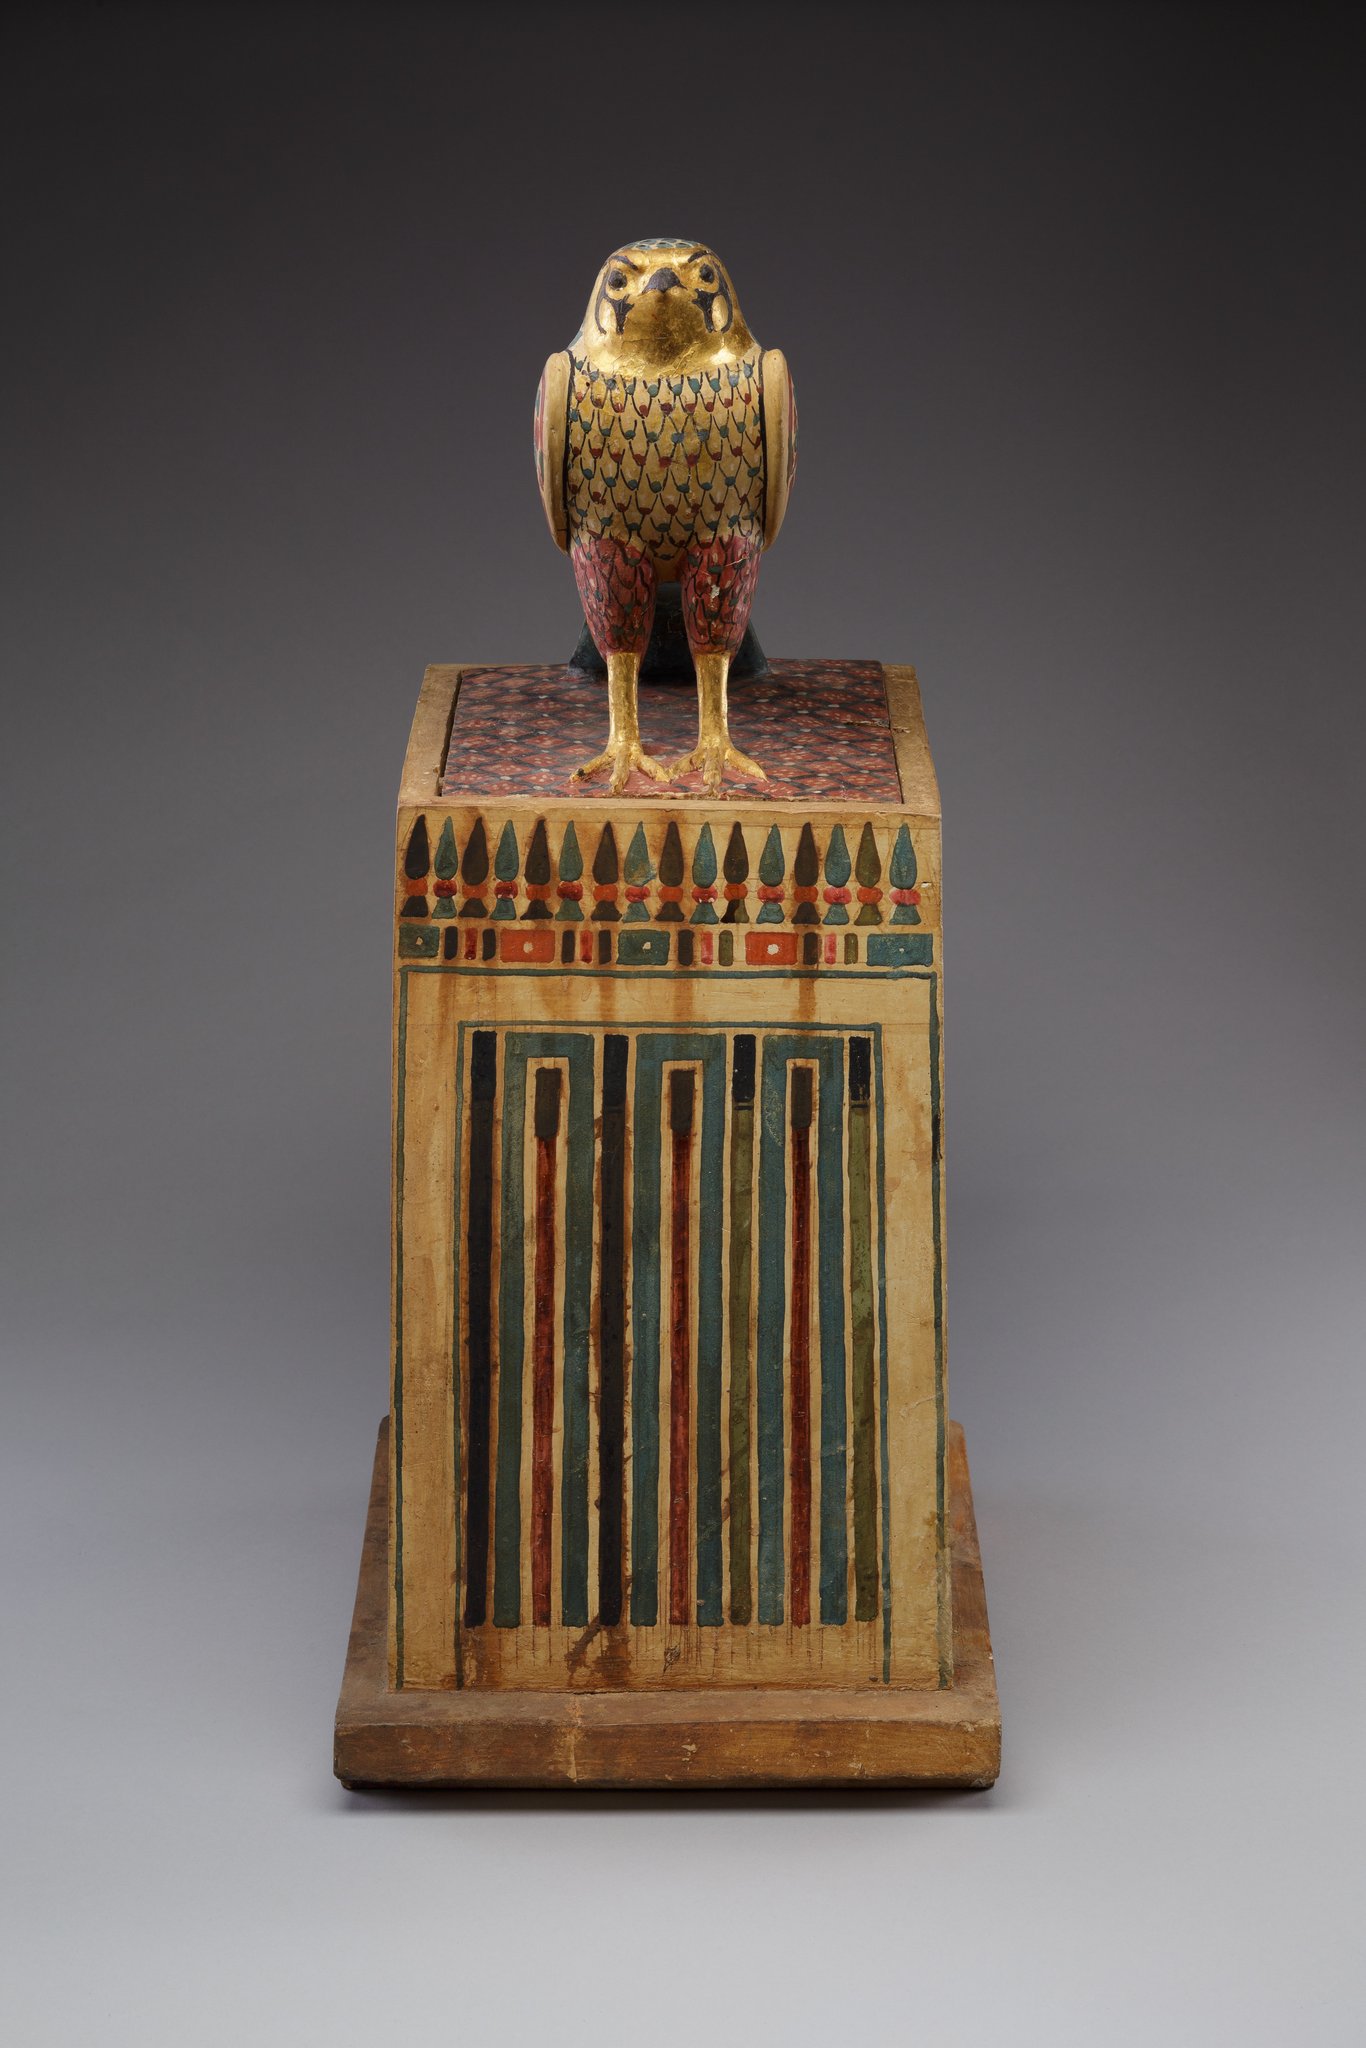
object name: falcon, mummy, chest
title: Falcon Box with Wrapped Contents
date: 600-30 BCE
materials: feather, linen, wood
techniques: gilding, painting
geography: middle egypt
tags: falcons